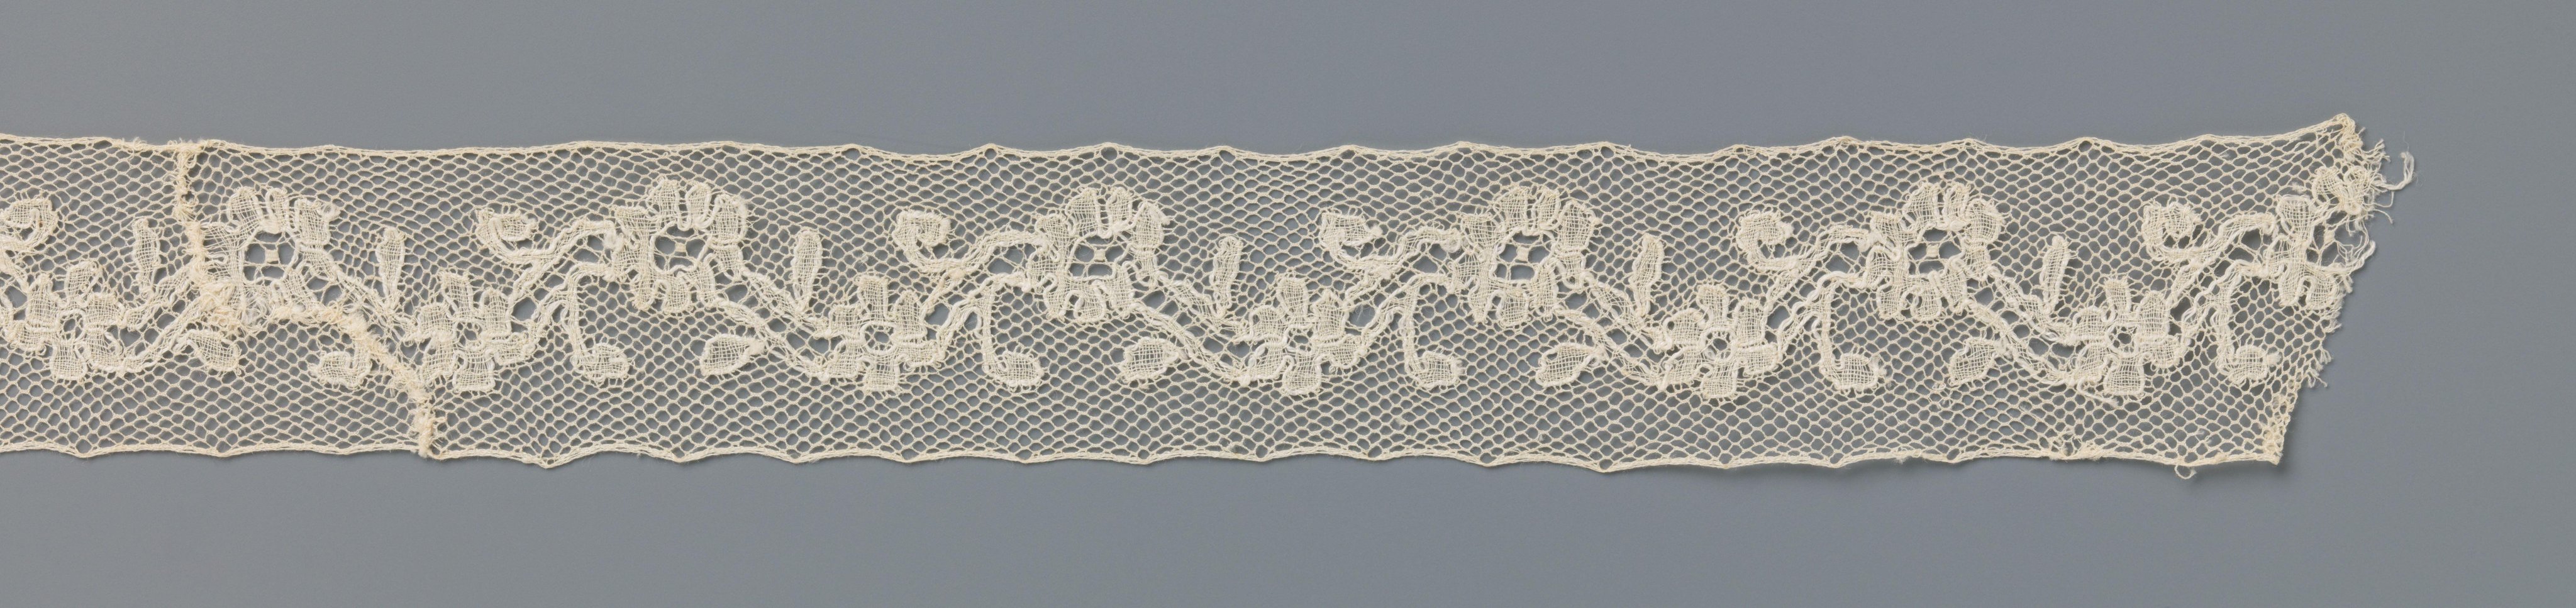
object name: entre deux, tussenzetsel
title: Tussenzetsel van kloskant met zigzaglijn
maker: Anonymous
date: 1875-1949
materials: linen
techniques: lace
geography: belgium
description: Tussenzetsel van naturelkleurige kloskant: Mechelse kant. In het midden van de fijne traliegrond, een Mechelse grond (ook wel ijsgrond genoemd), loopt een opengewerkte band in zigzaglijn, oversneden door twee soorten rozetjes.